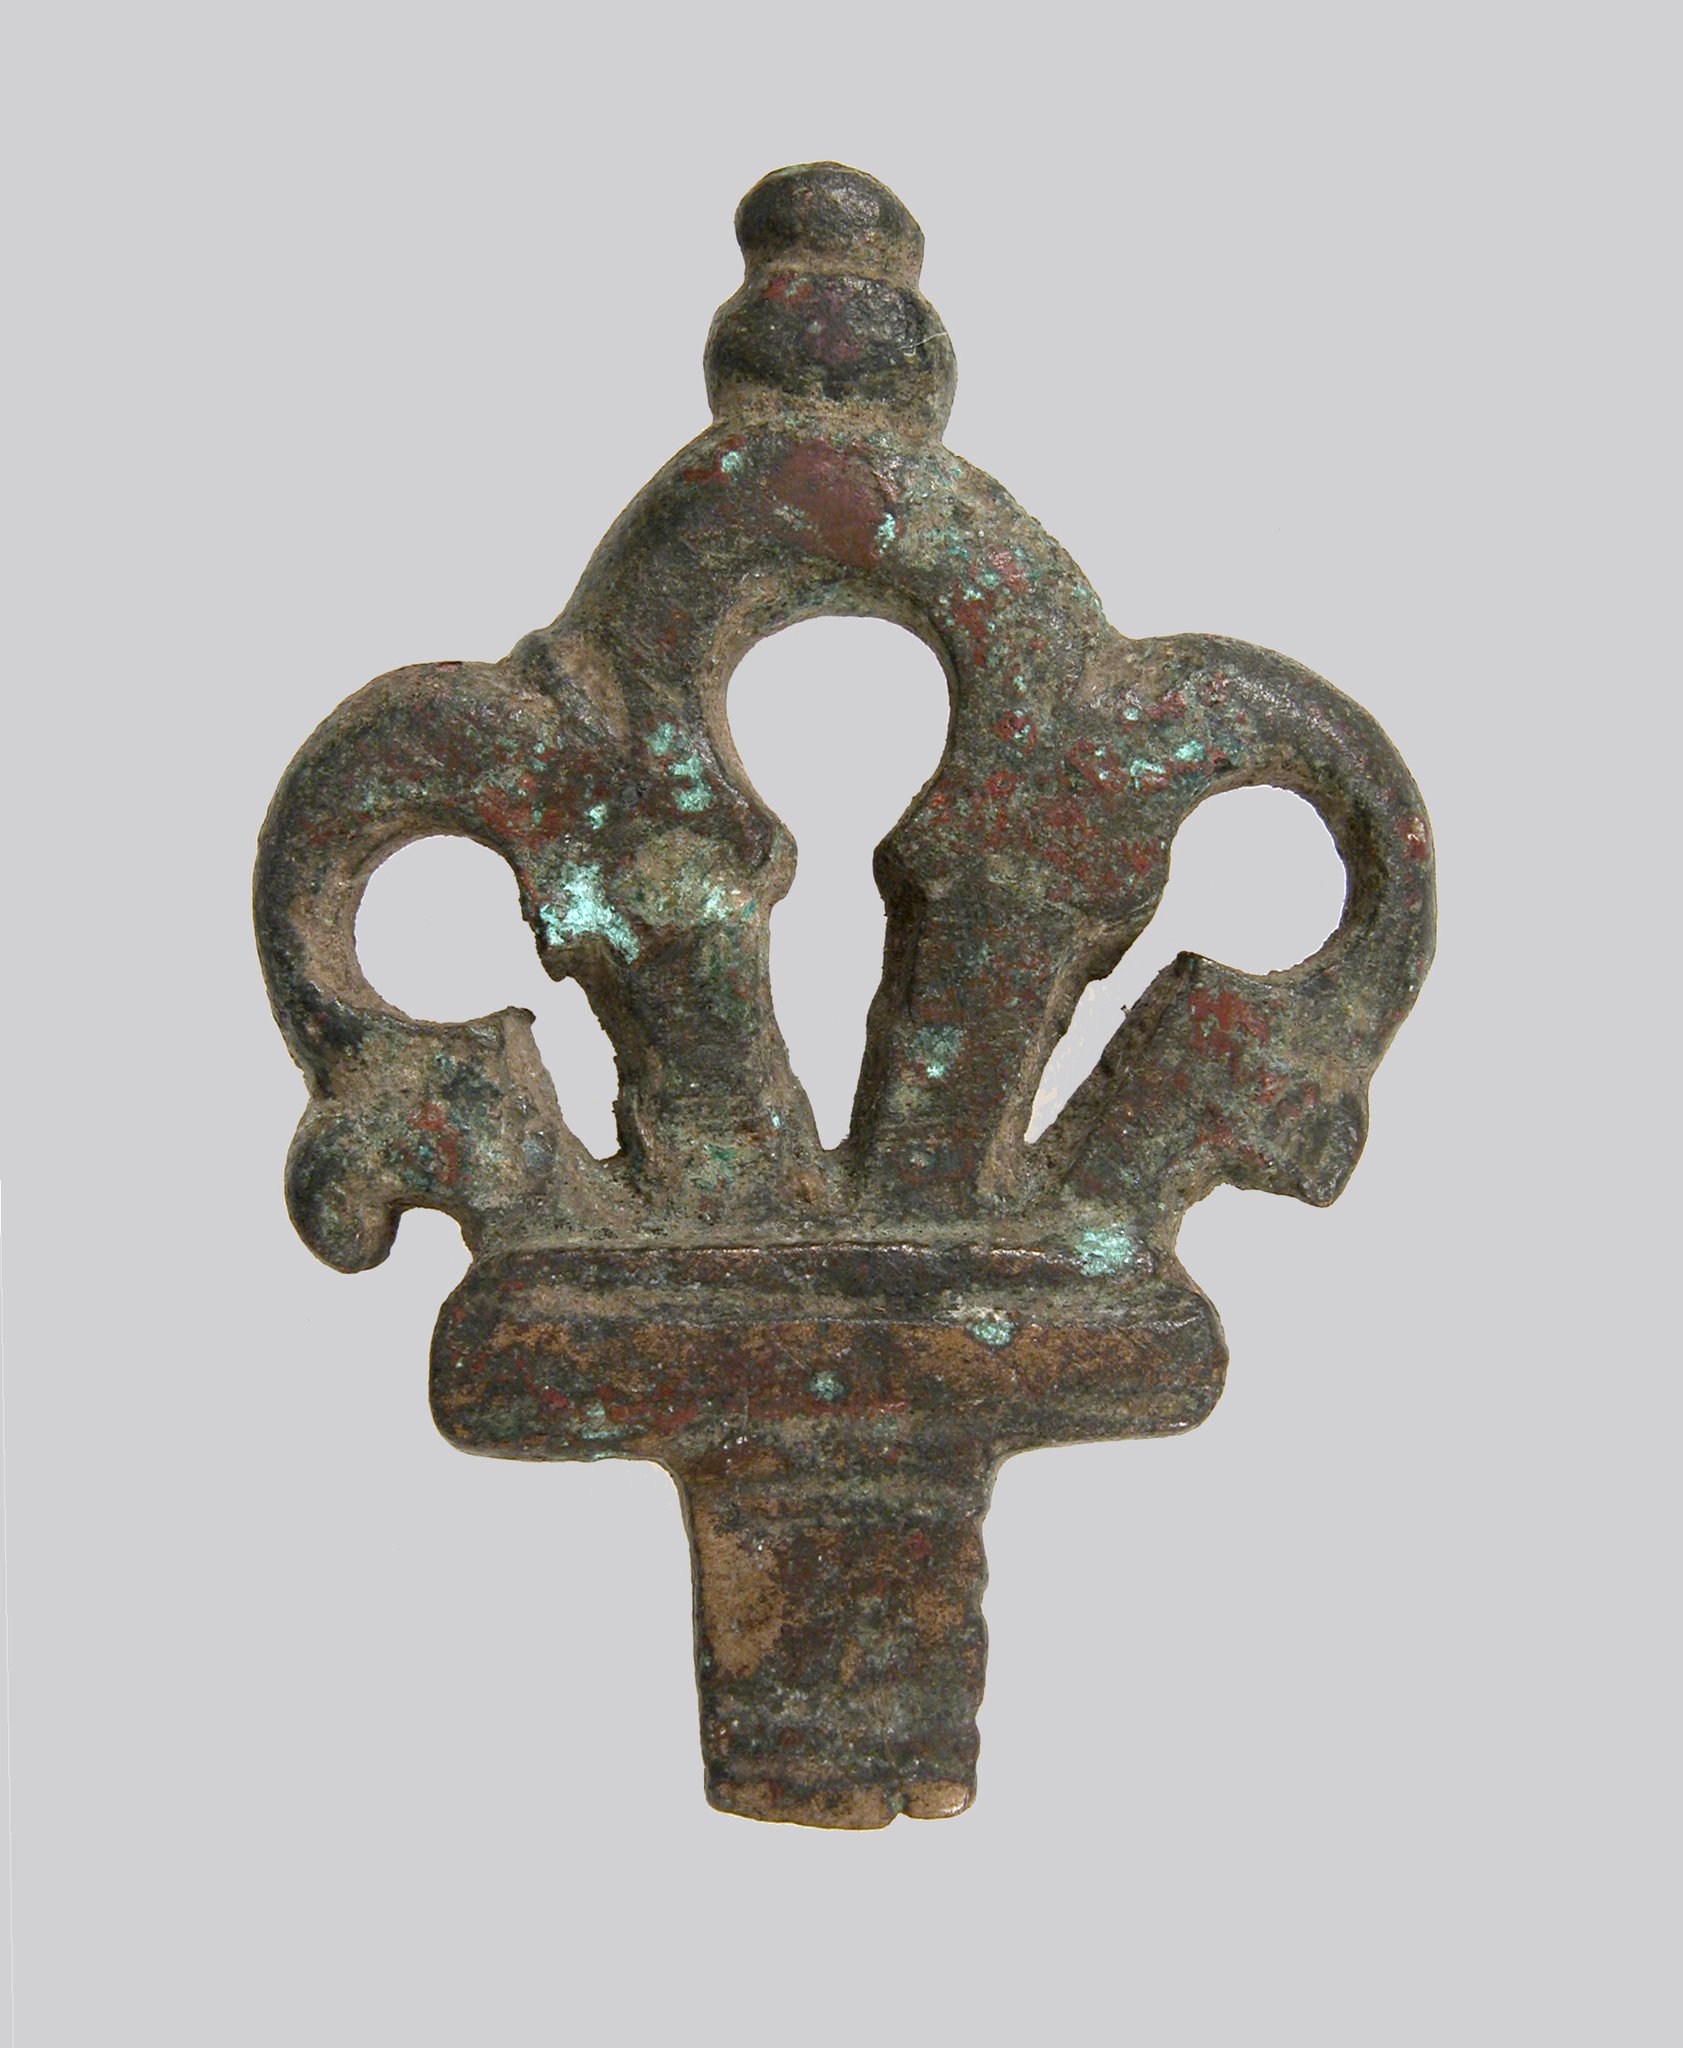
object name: key handle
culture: roman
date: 1-700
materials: copper alloy